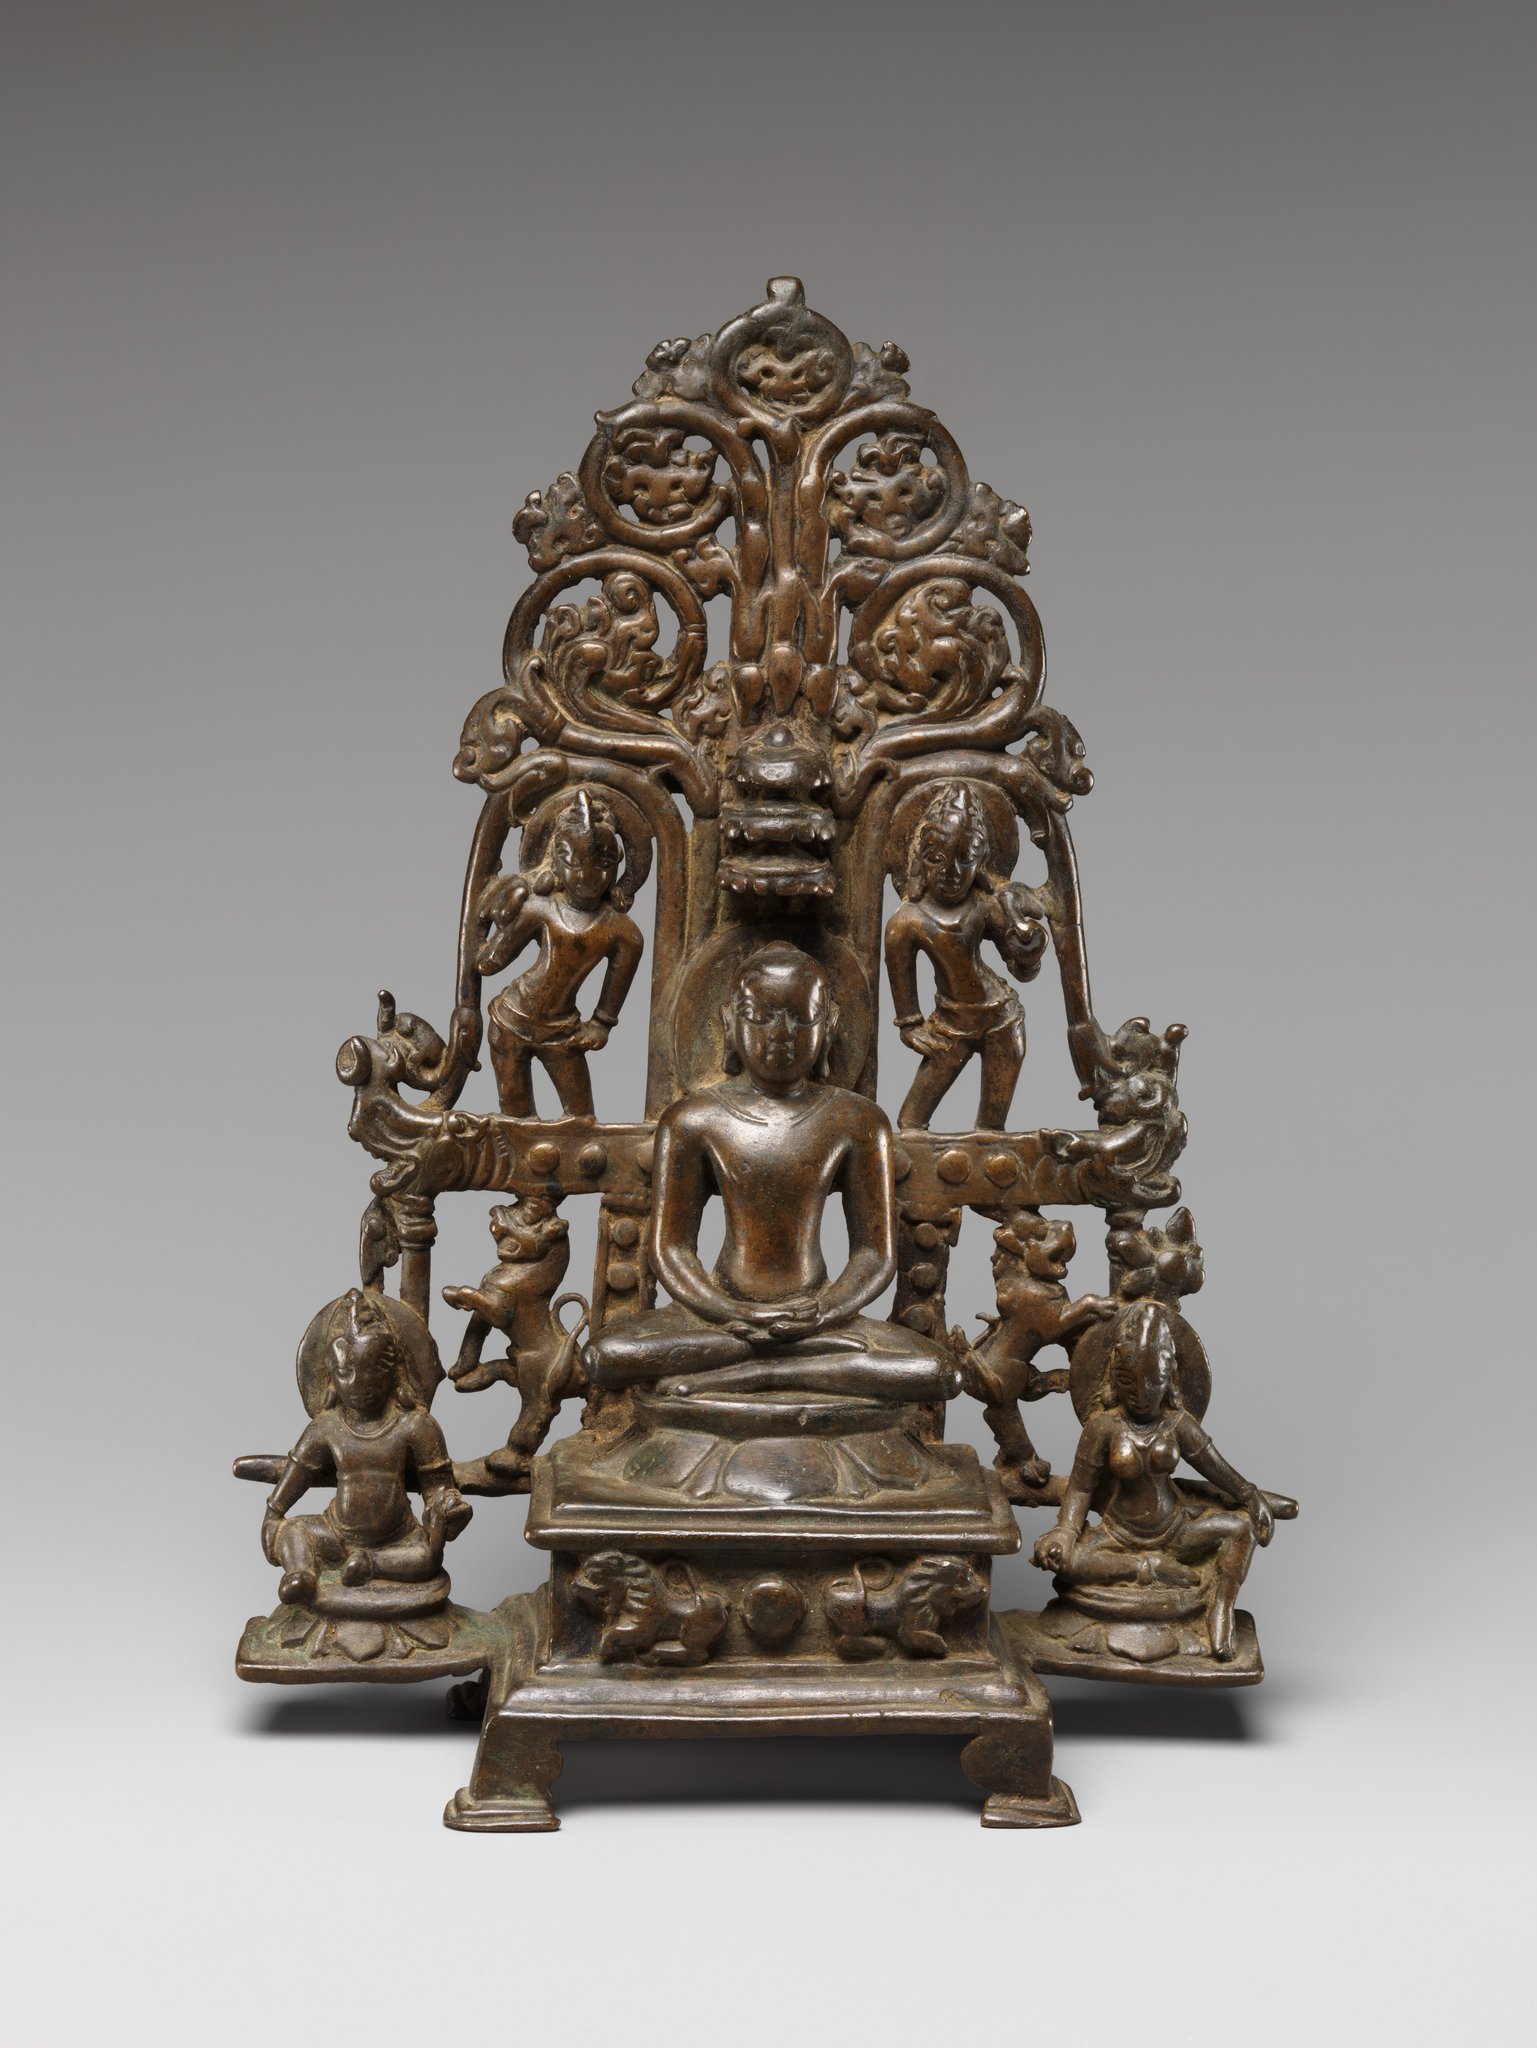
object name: figure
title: Enthroned Jina Attended by a Yaksha, a Yakshi, and Chauri-Bearers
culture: indian, karnataka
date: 801-1000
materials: copper alloy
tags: lions,deities